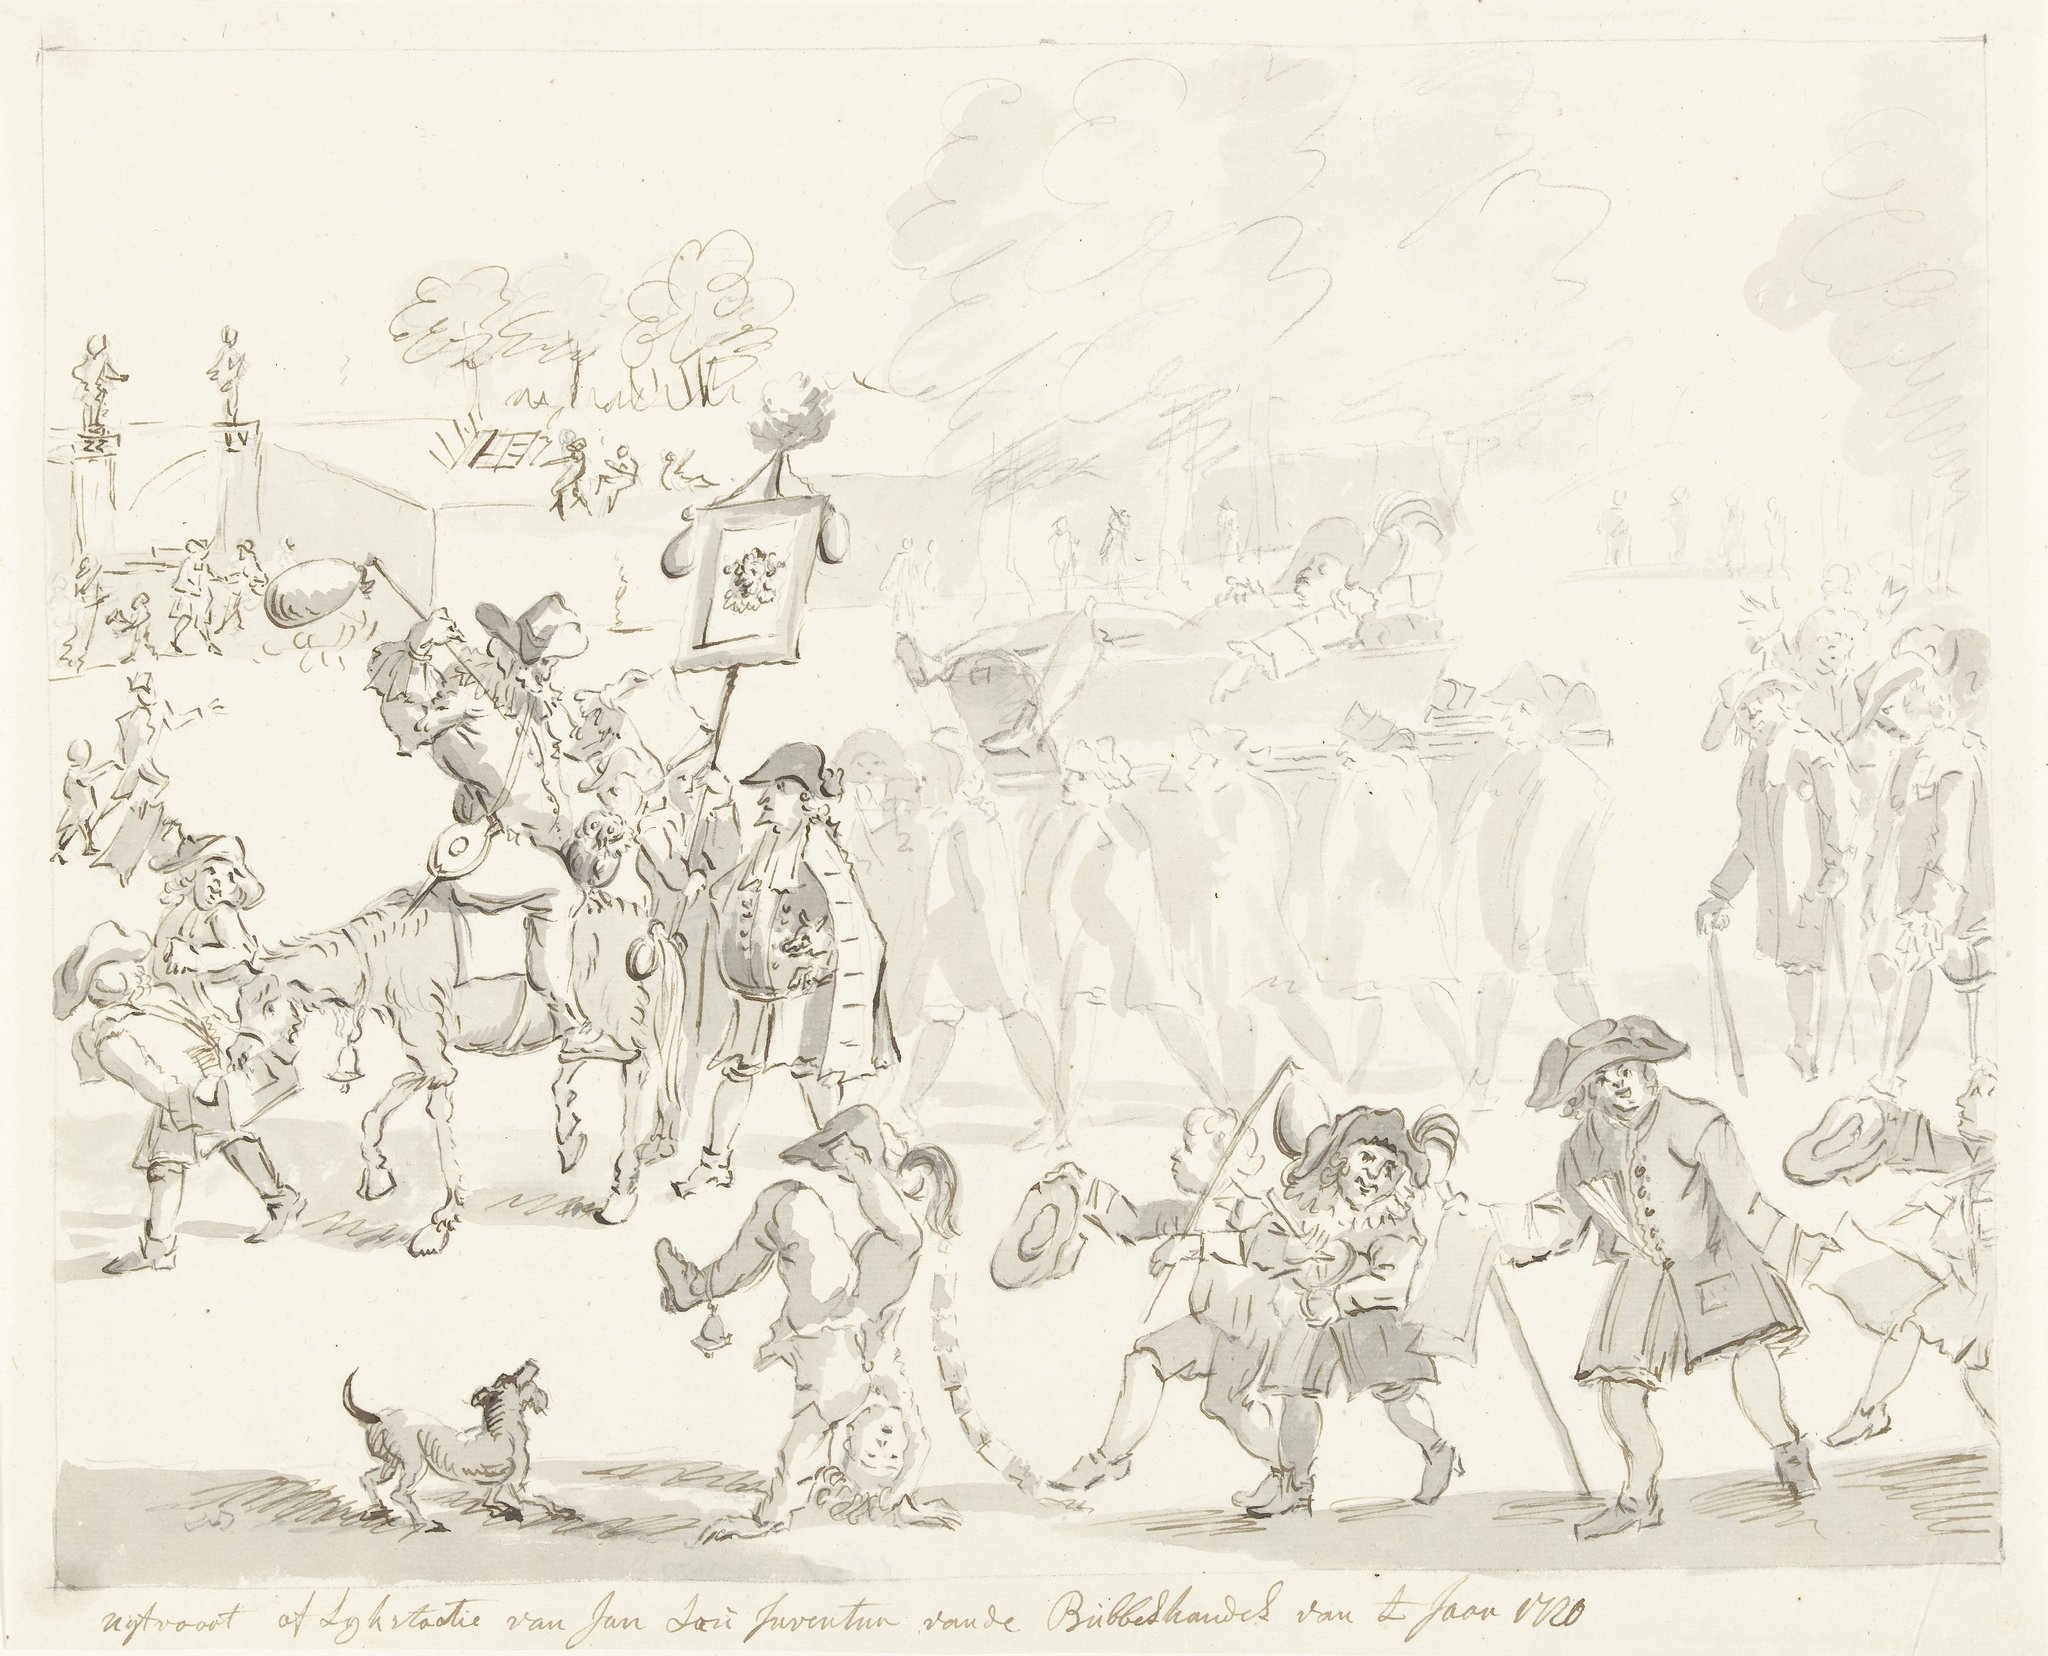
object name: cartoon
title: Uytvaart of Lykstaatie van Jan Lau Inventur van de Bubbelhandel van 't Jaar 1720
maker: Anonymous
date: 1720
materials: paper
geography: northern netherlands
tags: cortege, funeral procession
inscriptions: collector's mark: Lugt 2228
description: Begrafenisoptocht van John Law, de uitvinder van de windhandel. Stoet voorafgegaan door Bombario achterstevoren op een oud paard. Law ligt op een te kleine kist, op de voorgrond spelende en lachende kinederen. Ontwerptekening voor een niet uitgevoerde prent in een serie over de opkomst en ondergang van Quincampoix (John Law). Behoort tot de groep van tekeningen toegevoegd aan de serie Tafereel der Dwaasheid met spotprenten op de Windhandel of Actiehandel van 1720.